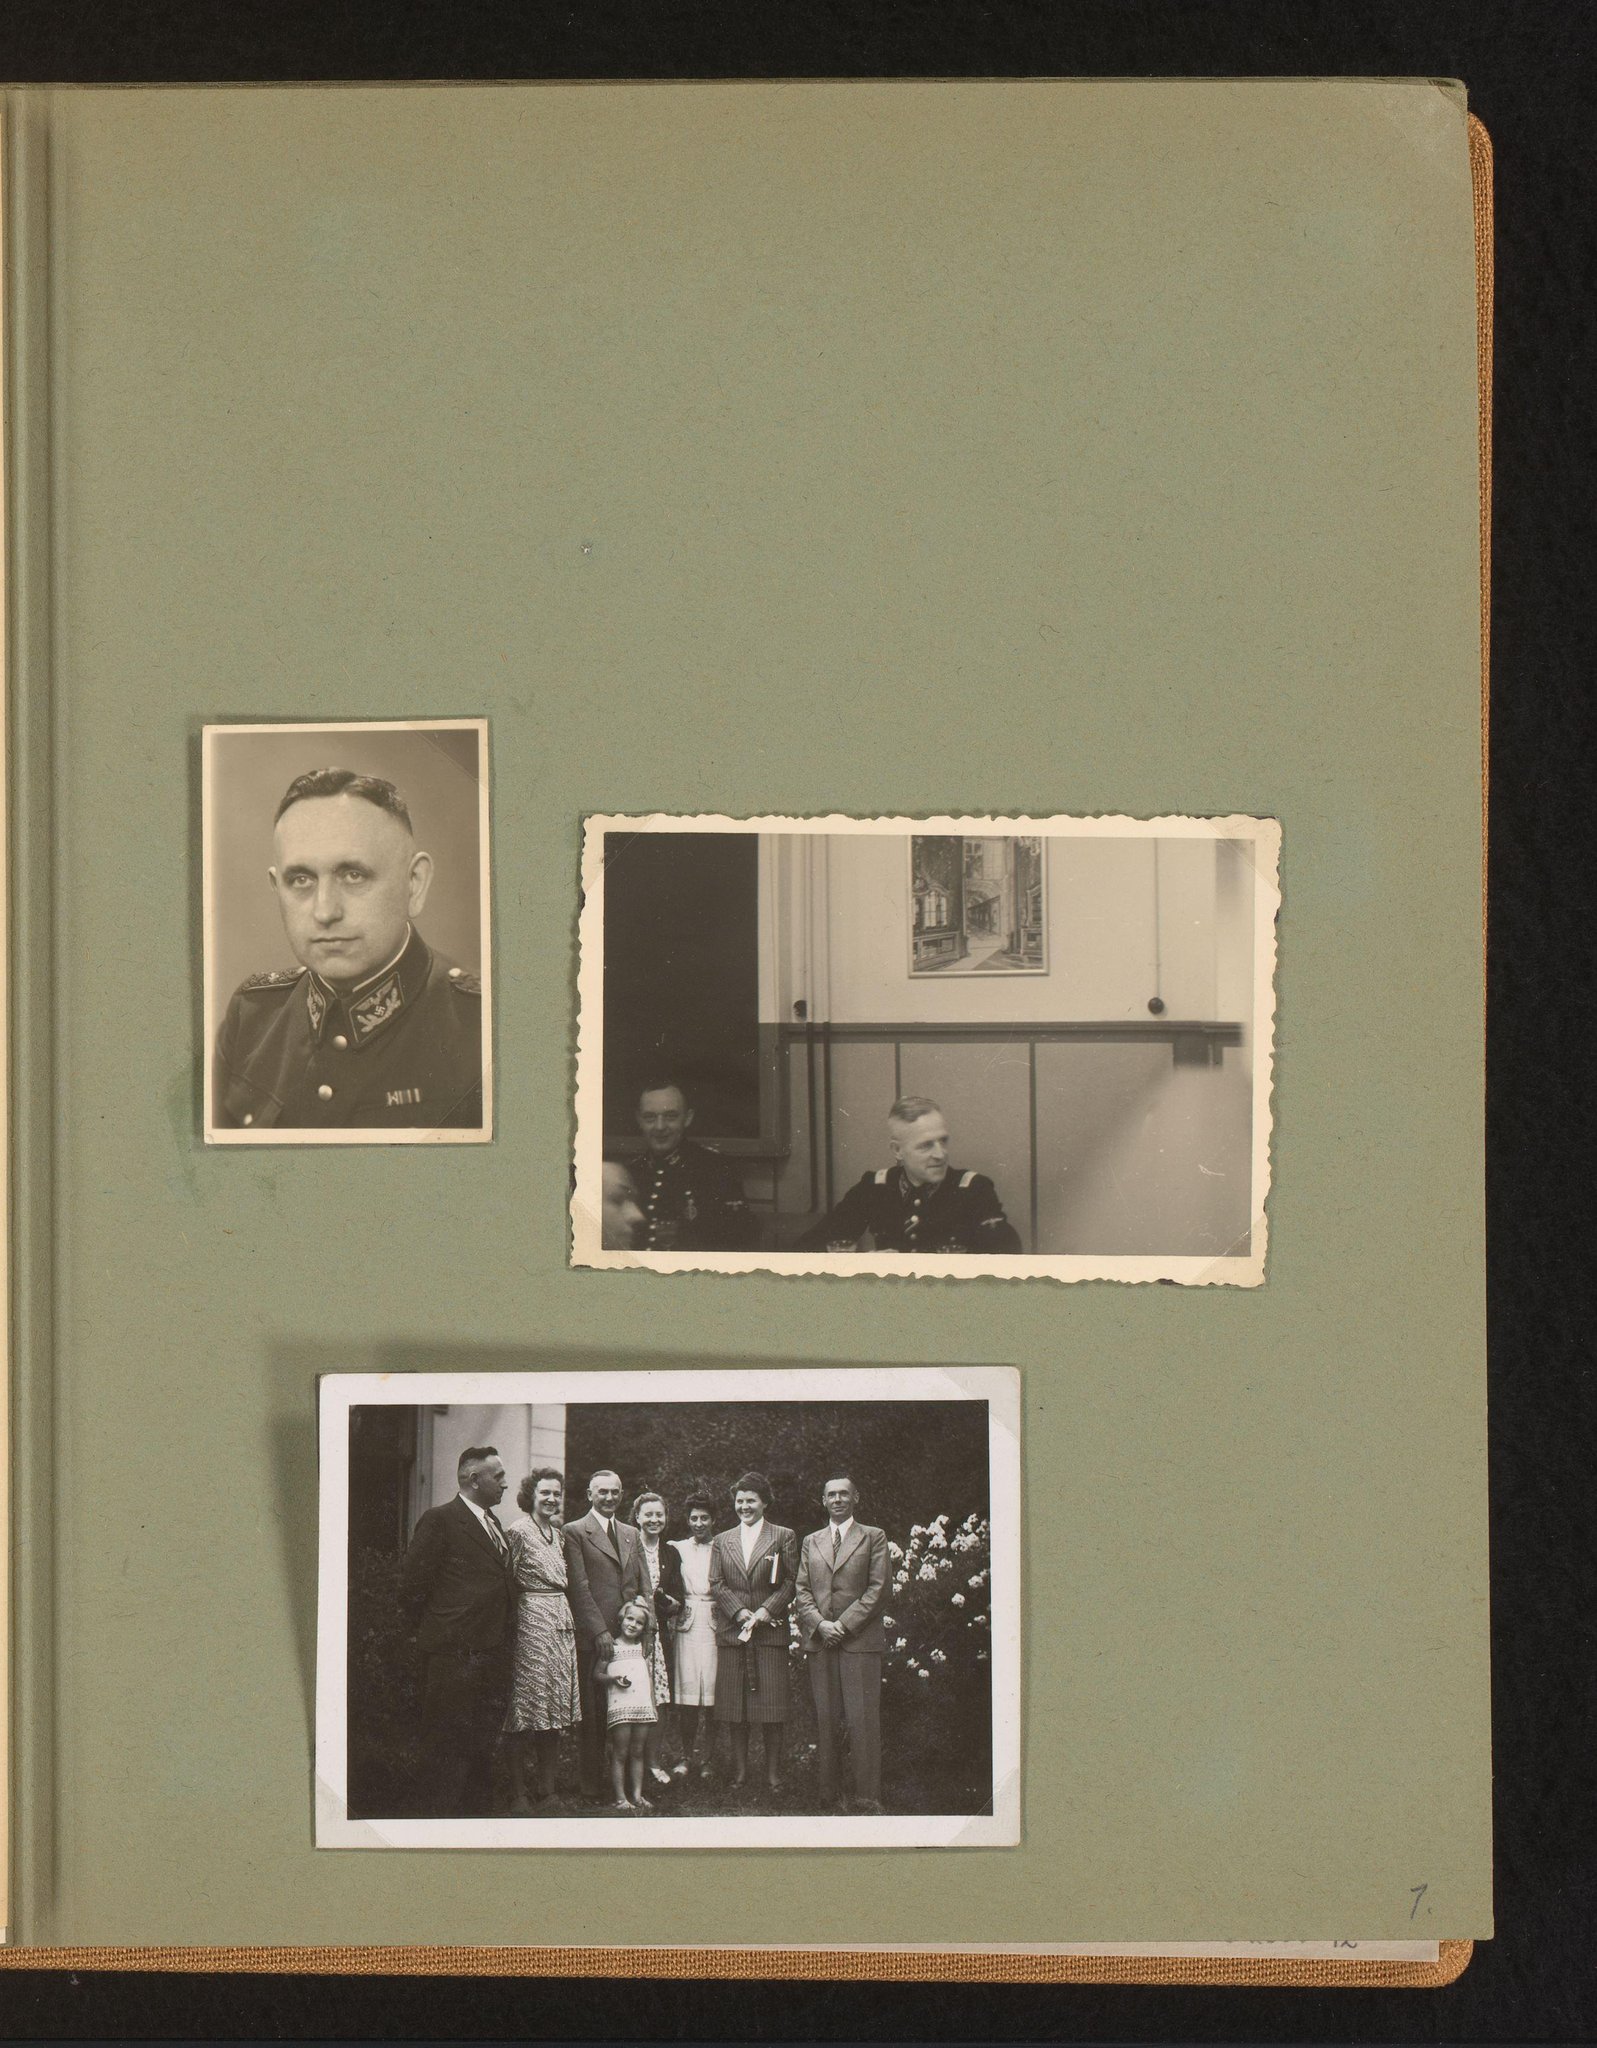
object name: photograph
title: Pasfoto, familiefoto en kerstviering in Utrecht, 1943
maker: Anonymous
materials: cardboard, photographic support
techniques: gelatin silver print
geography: utrecht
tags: christmas (non-liturgical celebration), railway-traffic, parents with their children, historical persons, utrecht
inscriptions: inscription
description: Albumblad met drie foto's van een officier van de Deutsche Reichsbahn in Nederland in 1944, pasfoto en familiefoto. Mogelijk is de pasfoto van de echtgenoot van Hedwig Schübert, de samensteller van het album. Kerstviering van de Deutsche Reichsbahn in Utrecht, 1943. Onderdeel van het fotoalbum Deutsche Reichsbahn, 1943-1944.